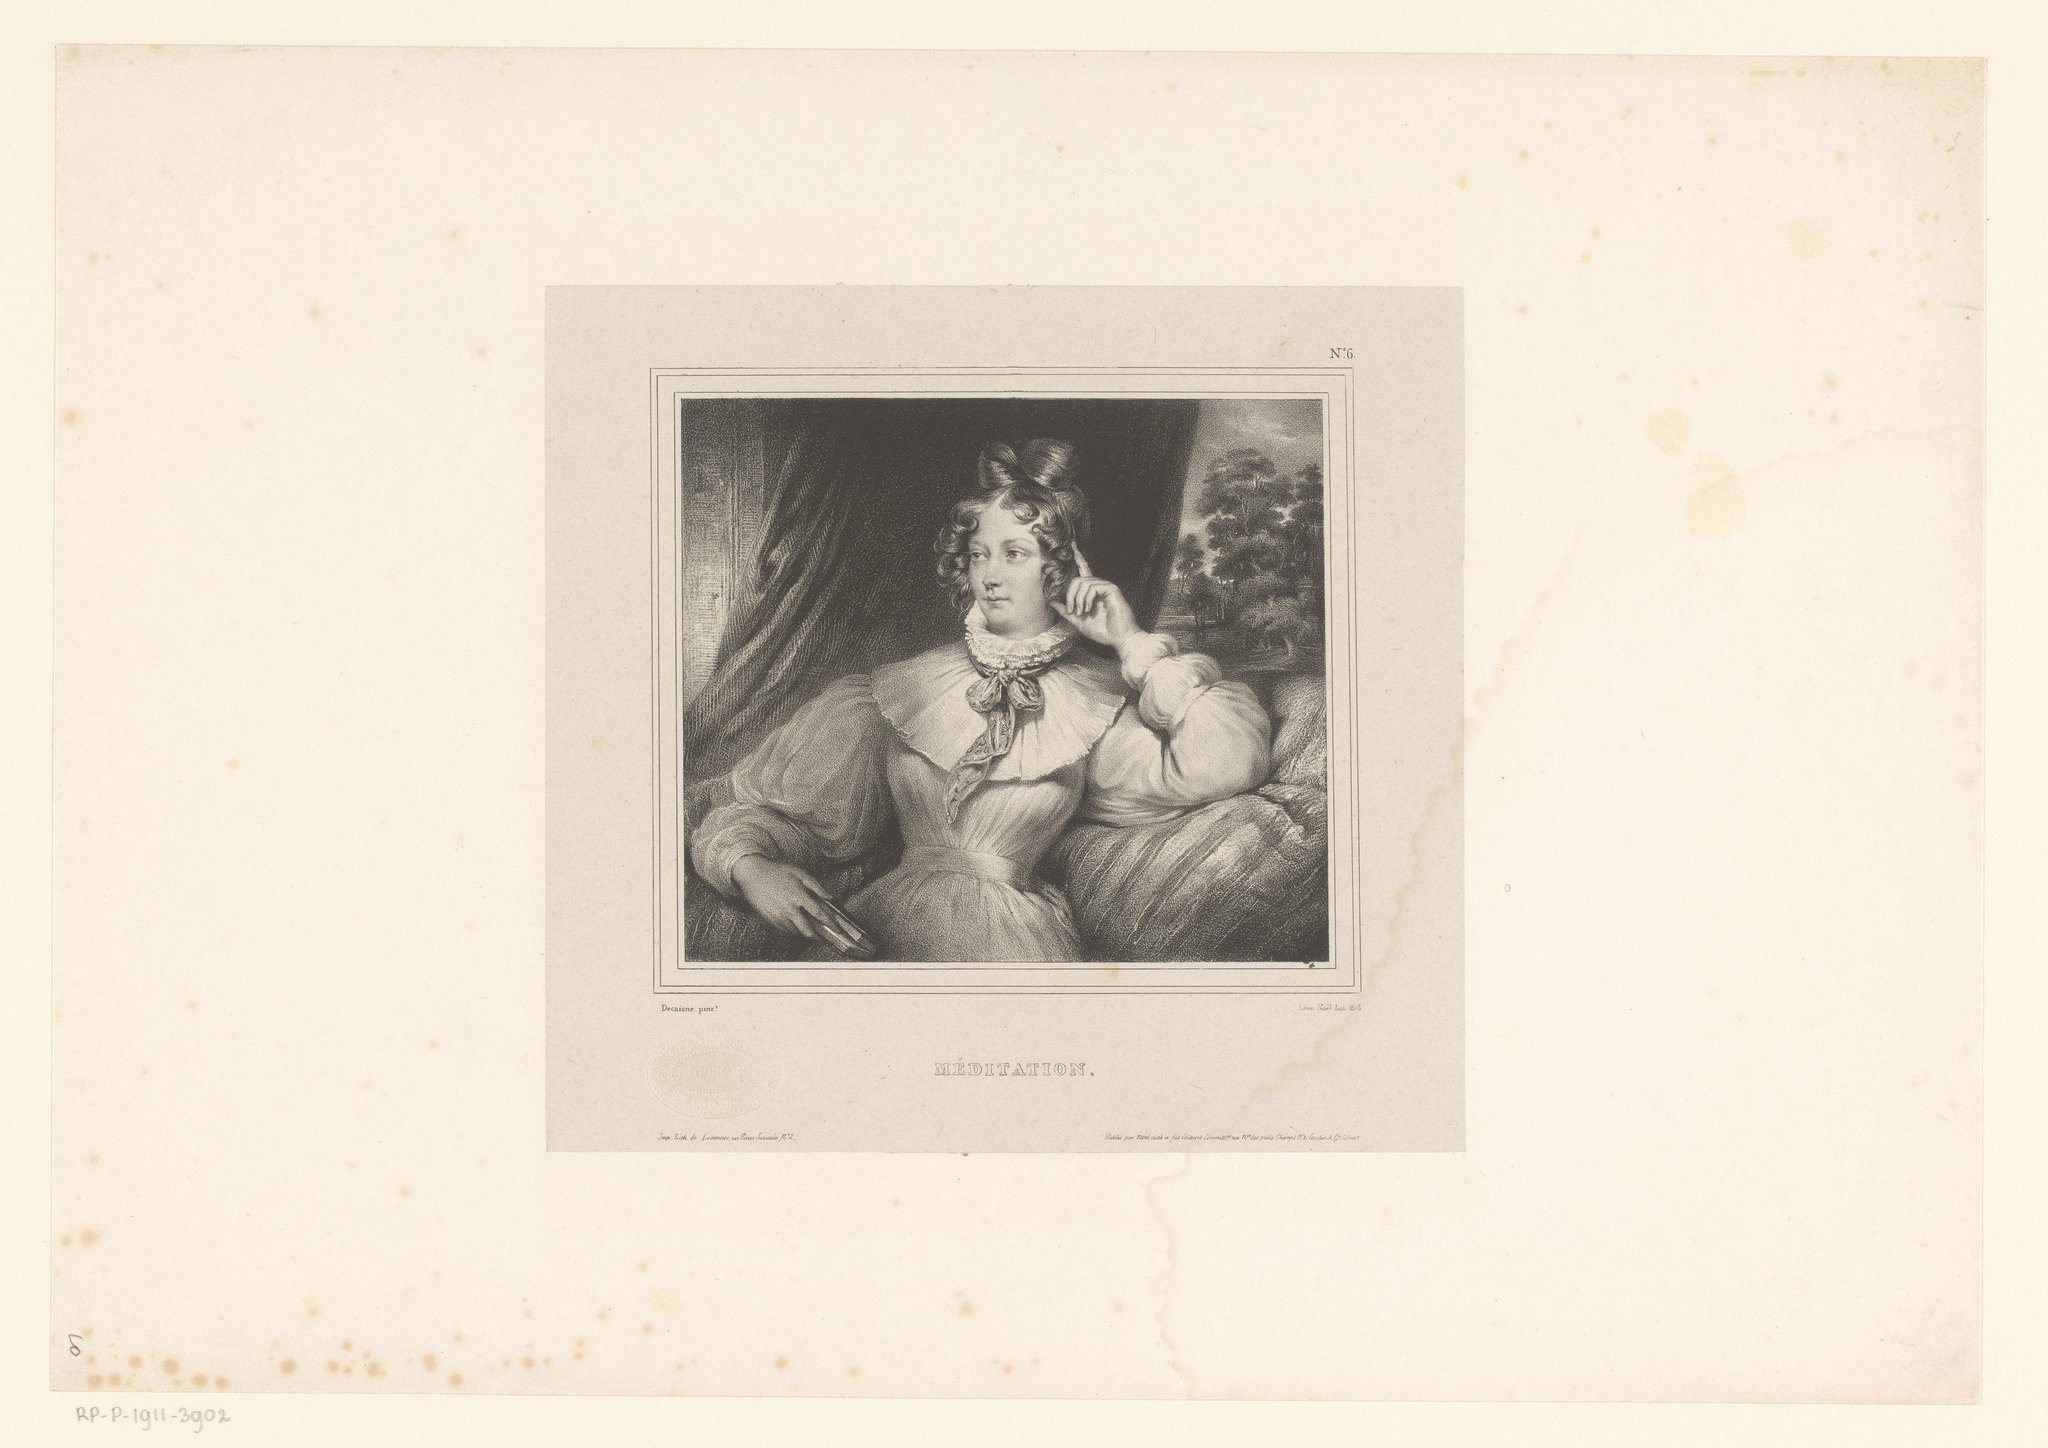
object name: print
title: Denkende vrouw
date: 1828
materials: paper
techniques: lithograph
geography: paris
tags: fashion, clothing, female sex; woman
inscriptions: check stamp: Lugt 4944, collector's mark: Lugt 2228